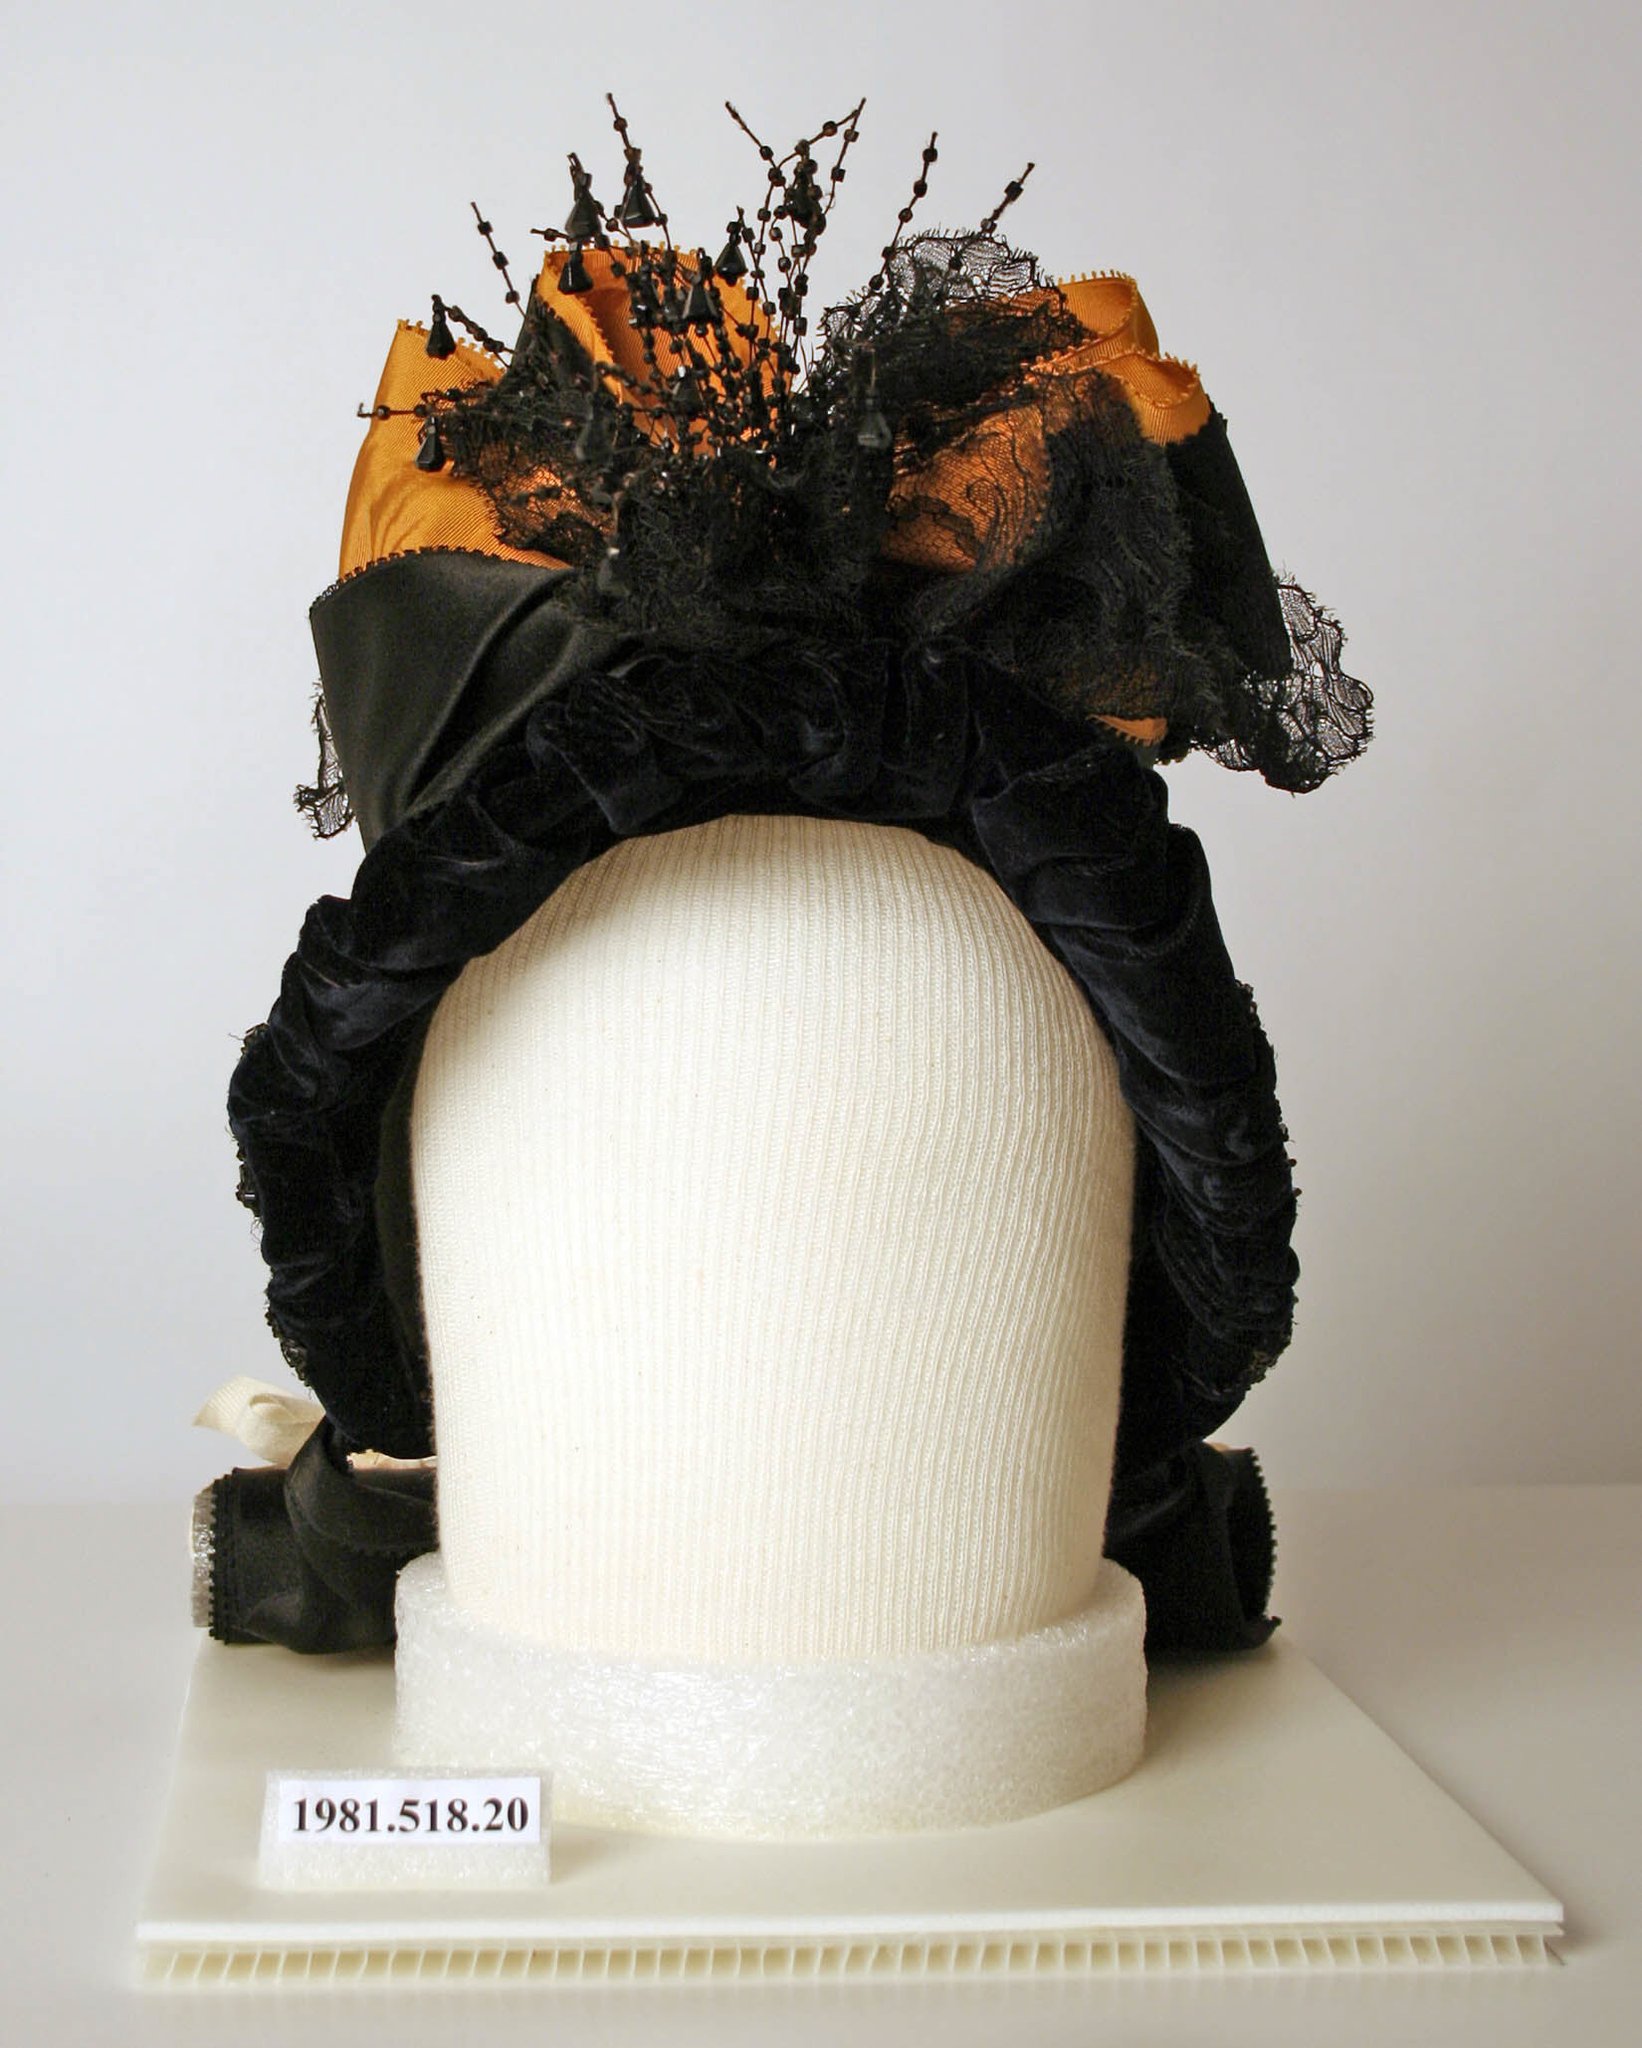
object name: hat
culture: american or european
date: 1888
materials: silk